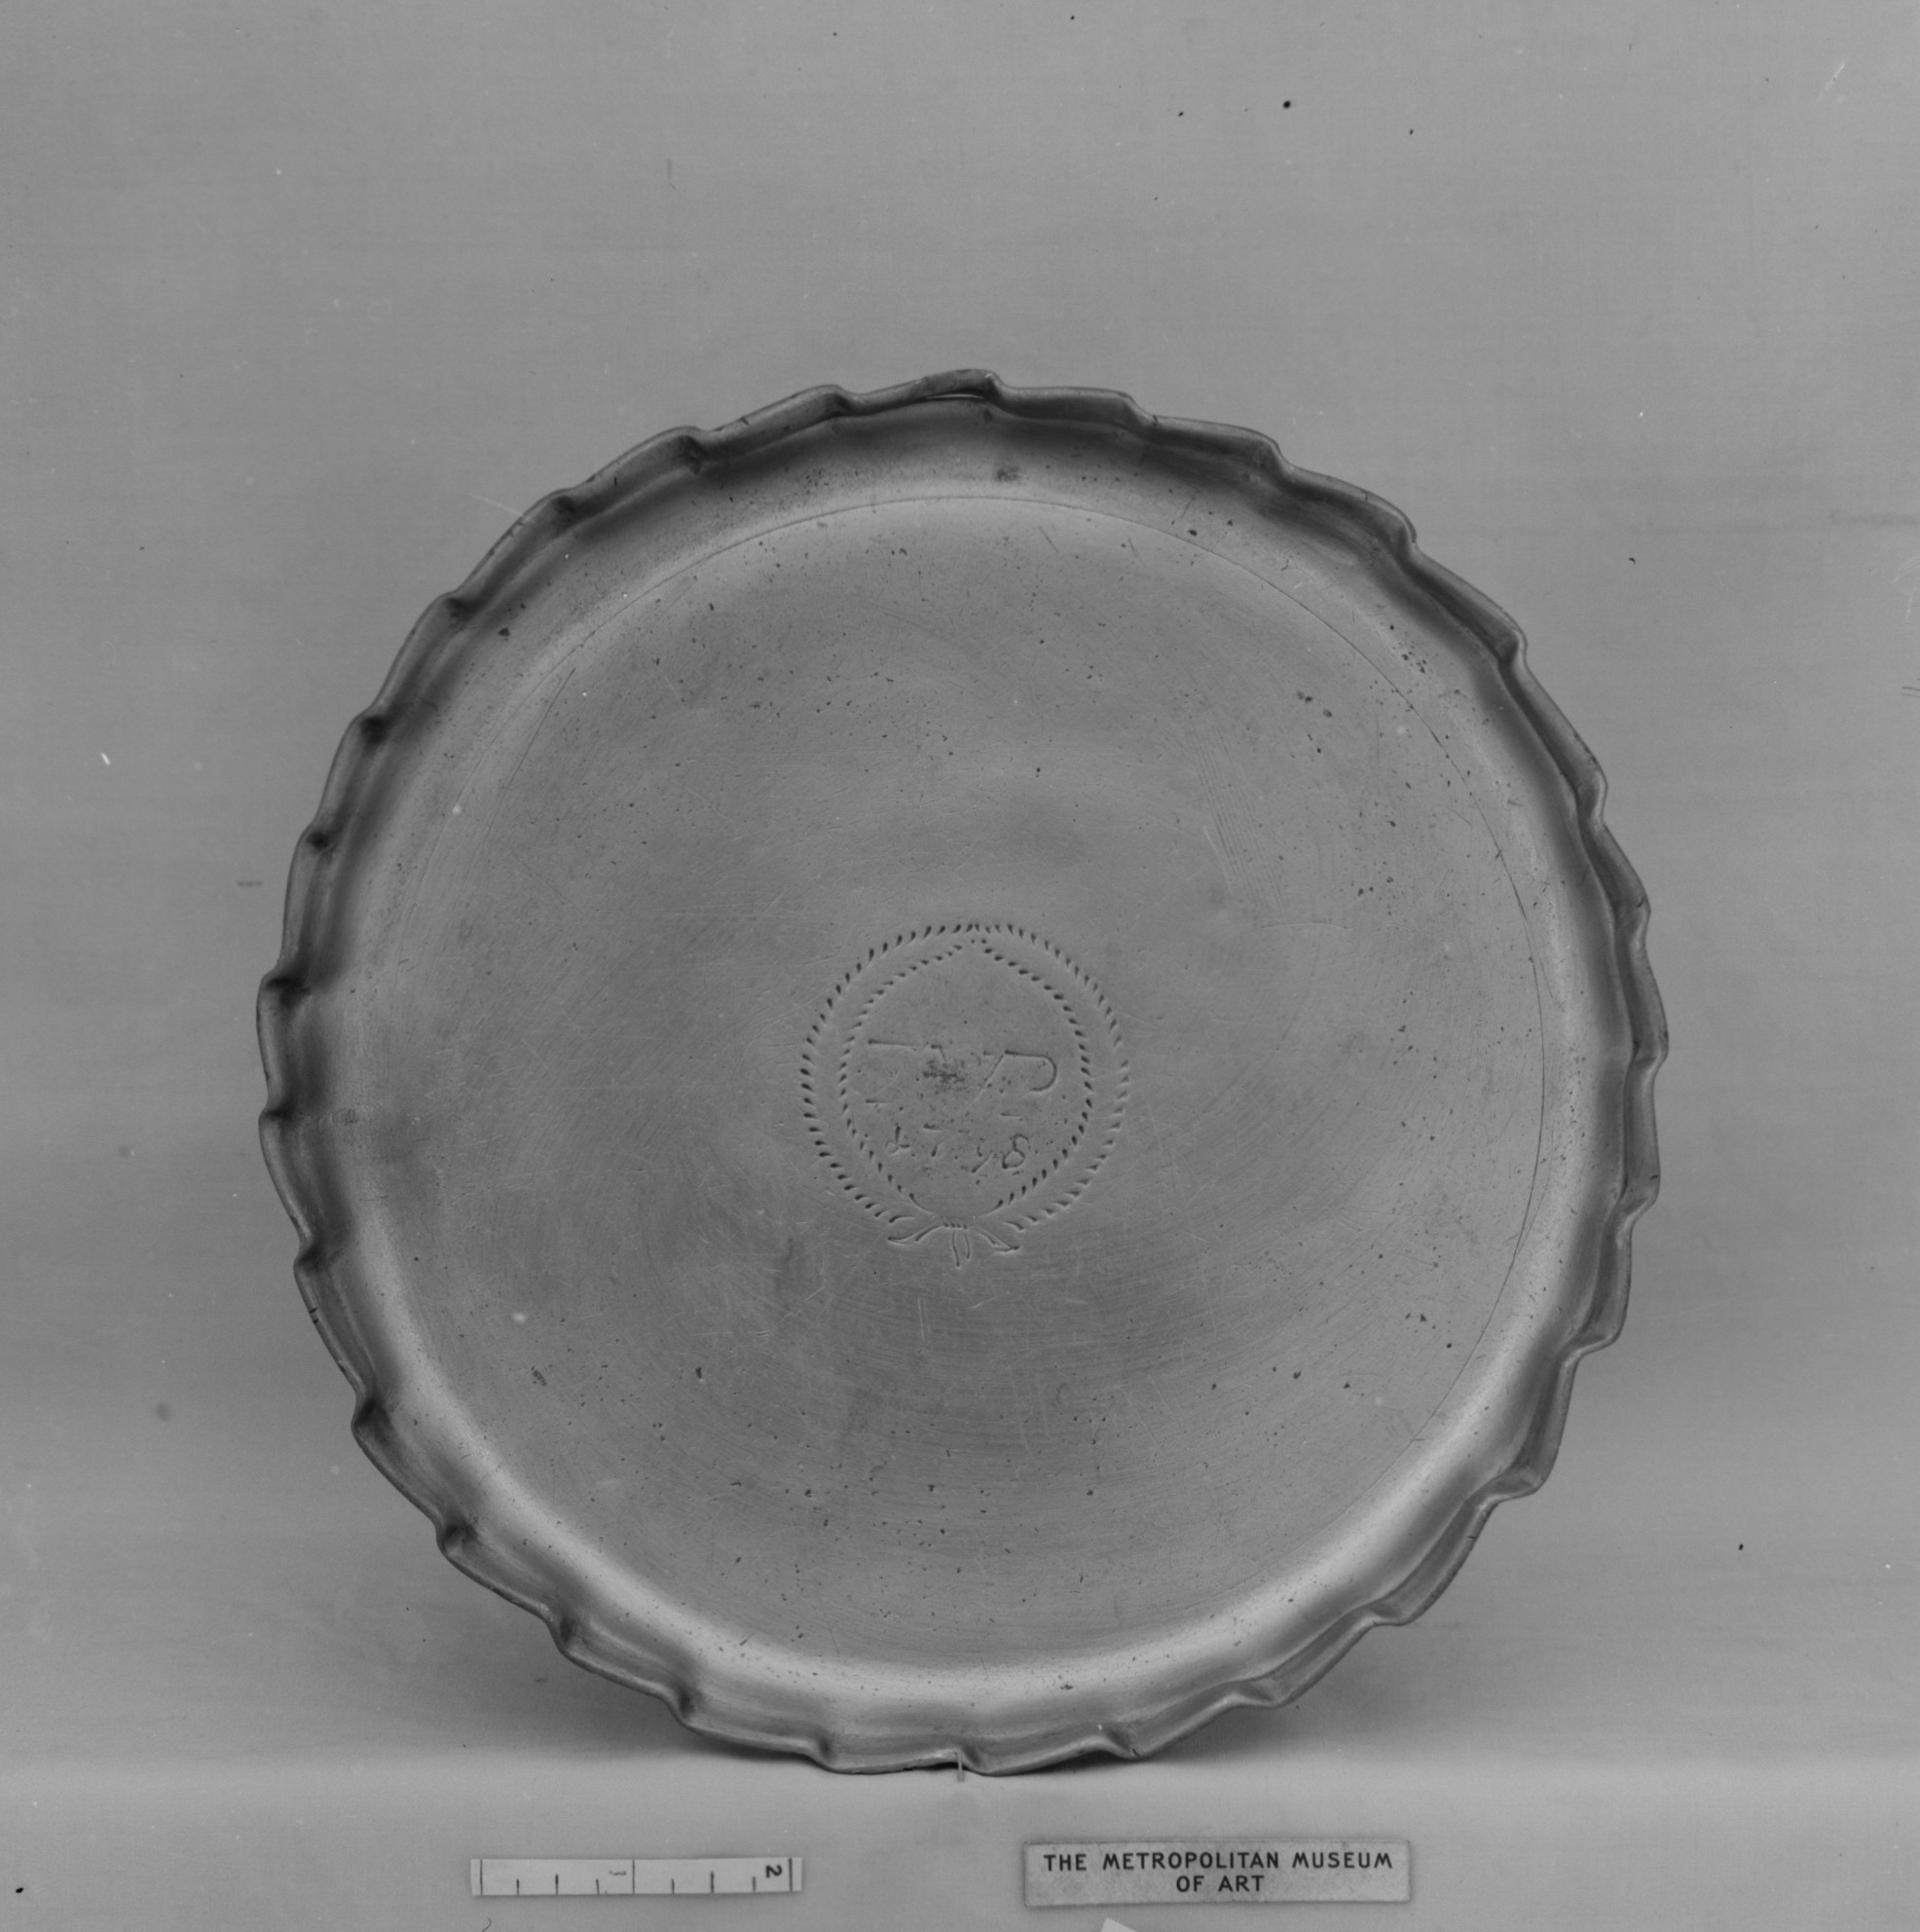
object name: plate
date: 1701-1800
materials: pewter